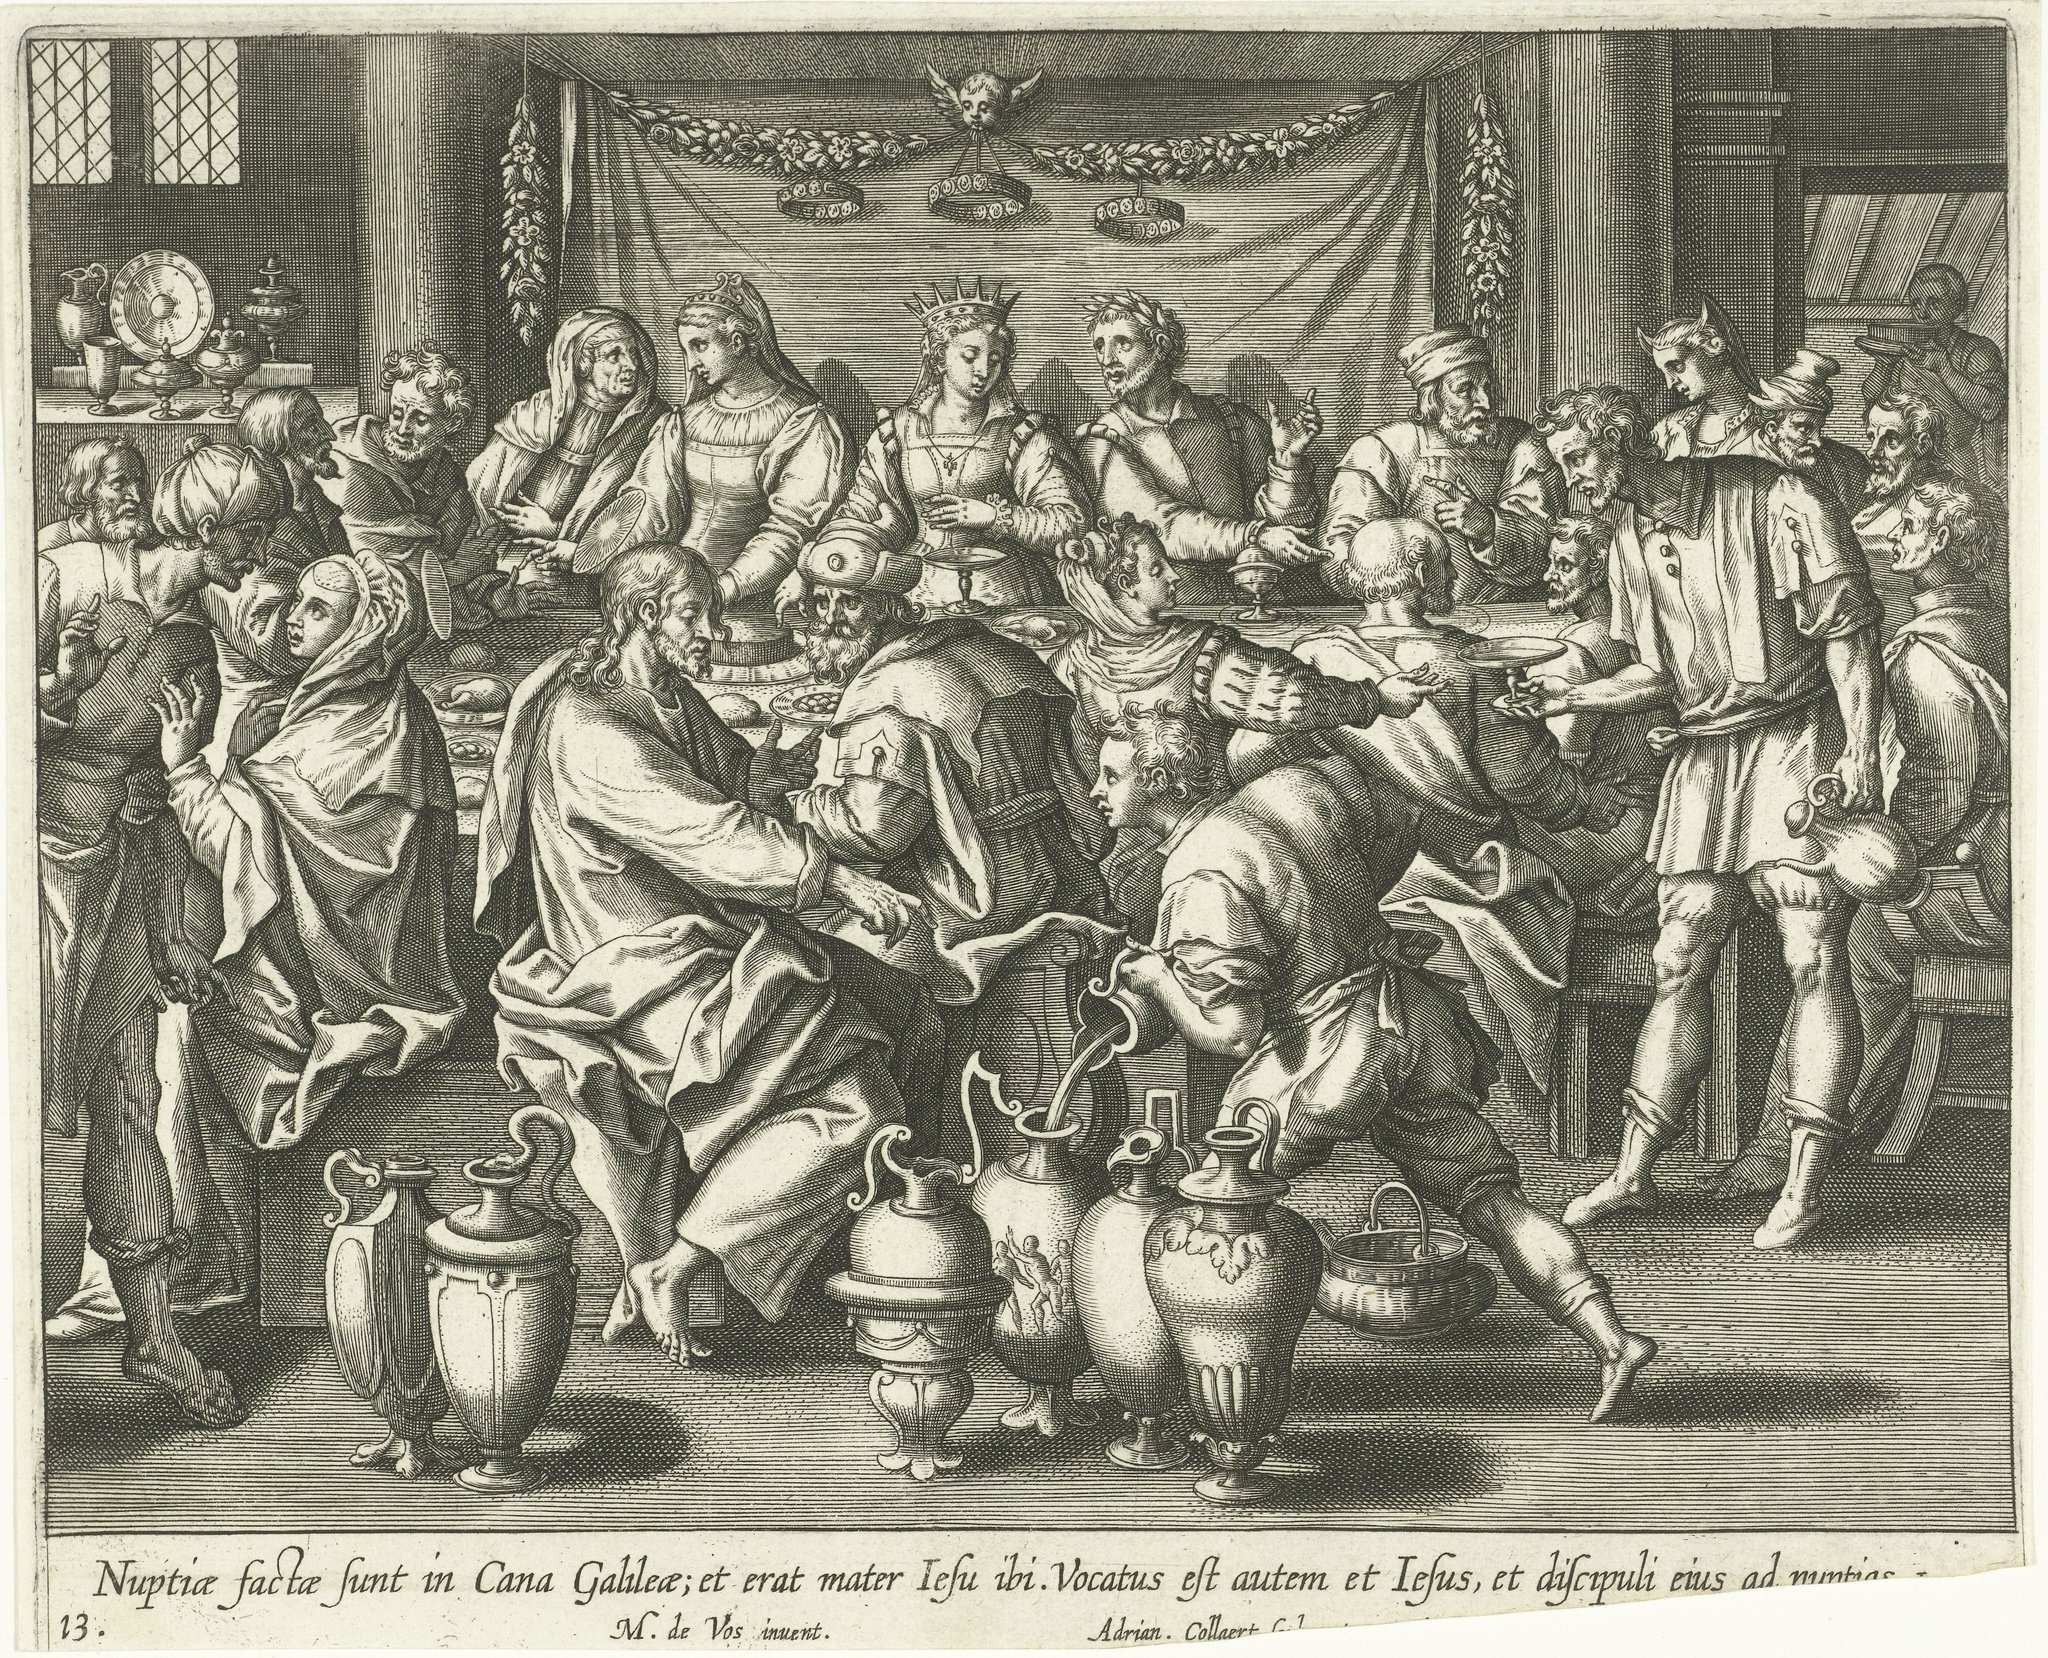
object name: print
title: Vita, passio et Resvrrectio Iesv Christi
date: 1598-1618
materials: paper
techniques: engraving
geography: antwerp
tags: christ orders (six) jars to be filled with water ~ marriage-feast at cana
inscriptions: collector's mark: Lugt 2228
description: Op de bruiloft van Kana beveelt Christus zes kruiken met water te vullen. Vervolgens verandert hij het water in wijn (Johannes 2:1-11). De prent heeft een Latijns onderschrift. De prent maakt deel uit van een serie over het leven van Christus.